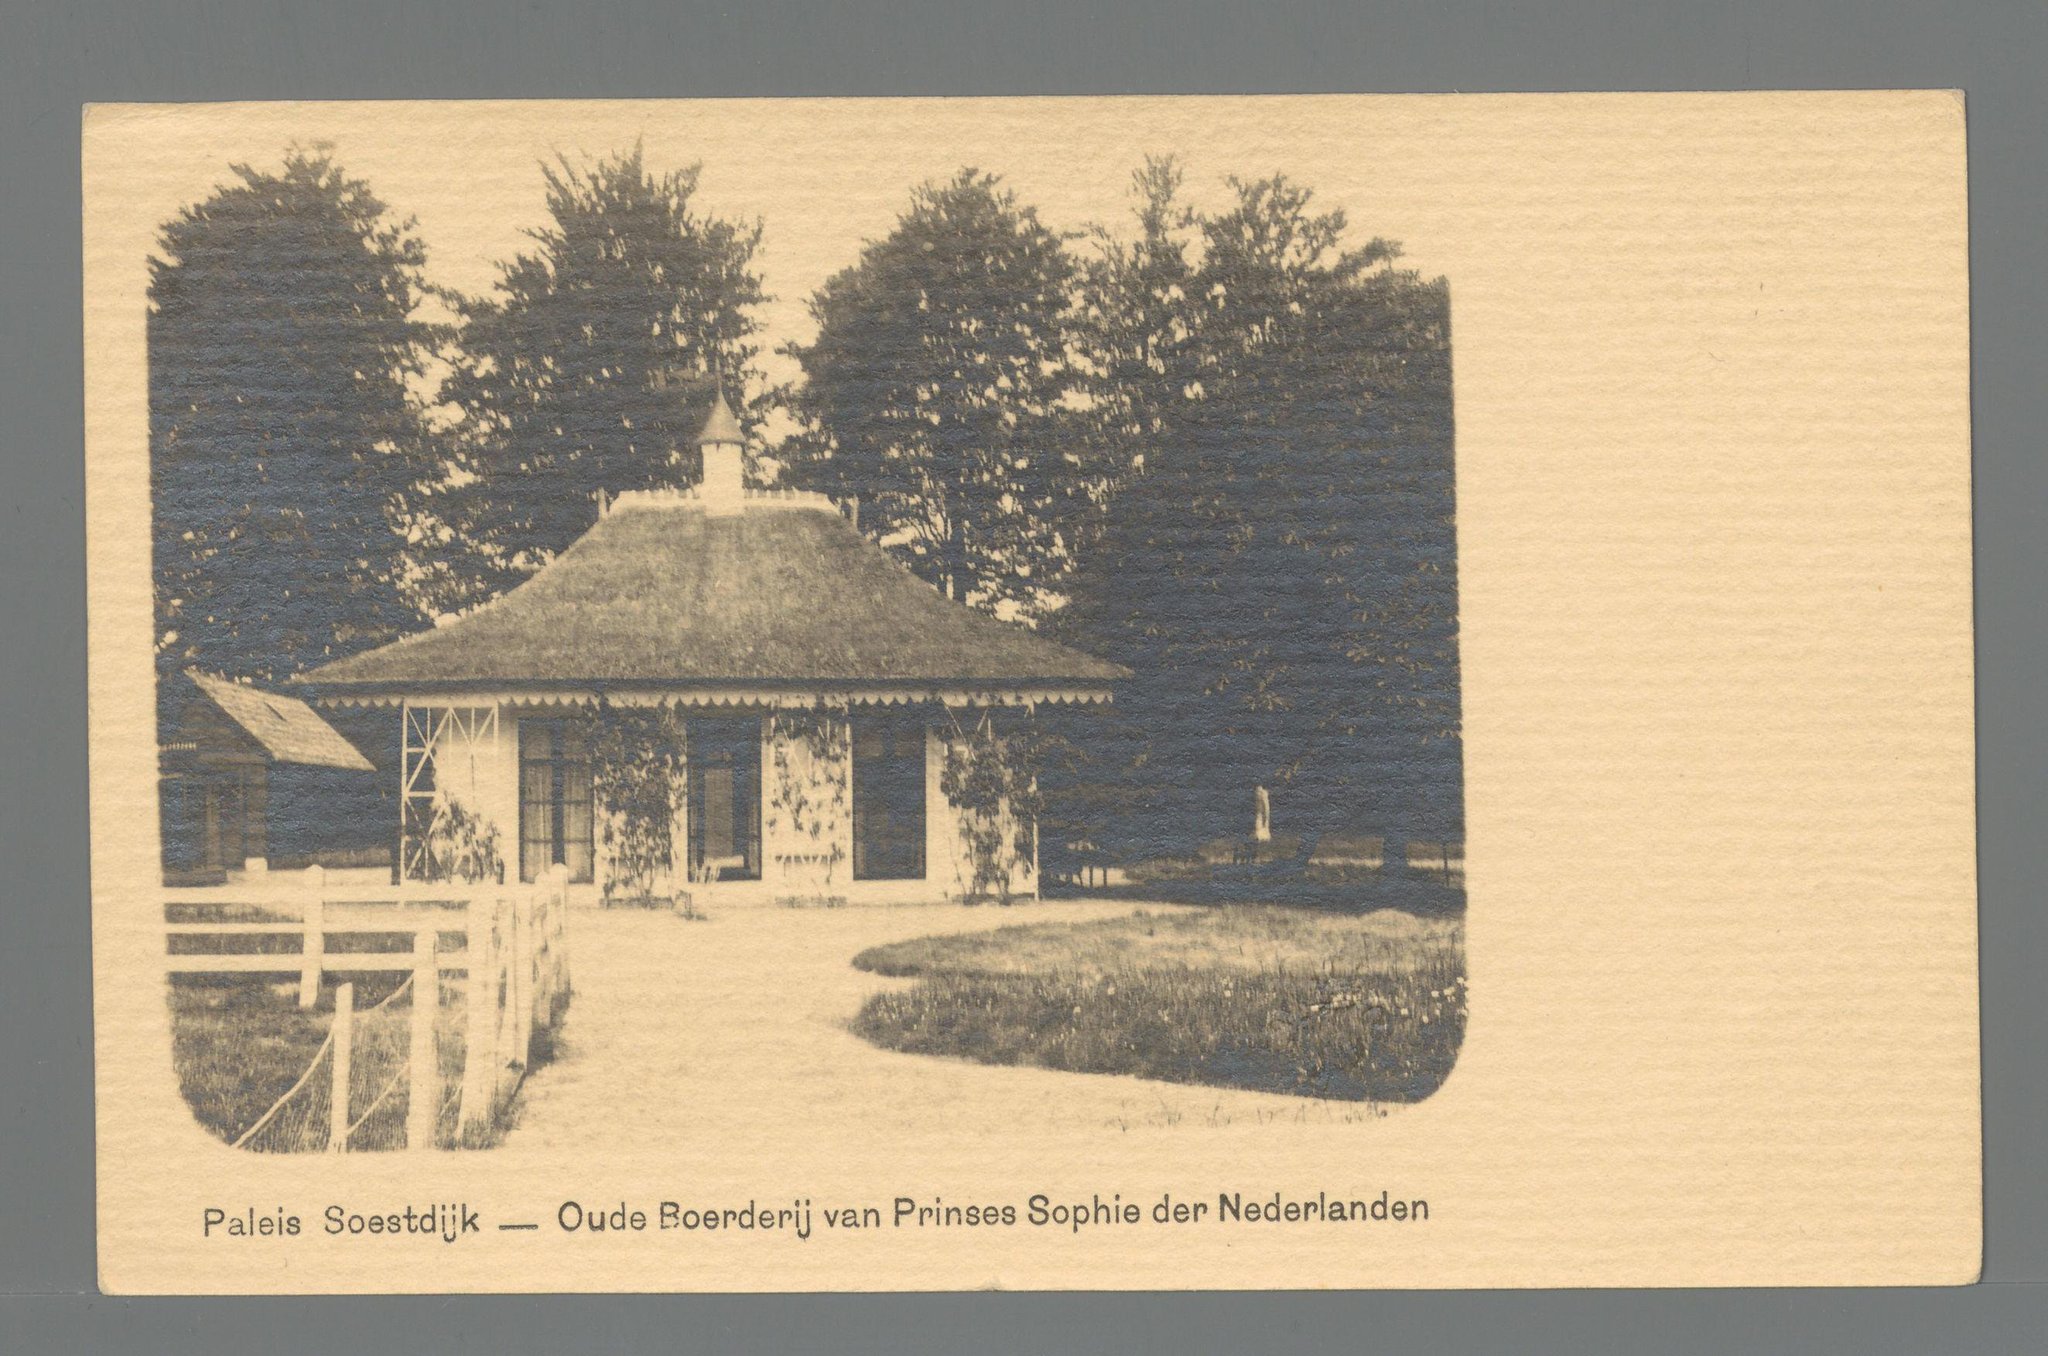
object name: ansichtkaart, prentbriefkaart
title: Paleis Soestdijk - Oude boerderij van Prinses Sophie der Nederlanden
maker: Anonymous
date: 1900-1905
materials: photographic support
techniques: gelatin silver print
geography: soestdijk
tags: farm (building)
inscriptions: check stamp